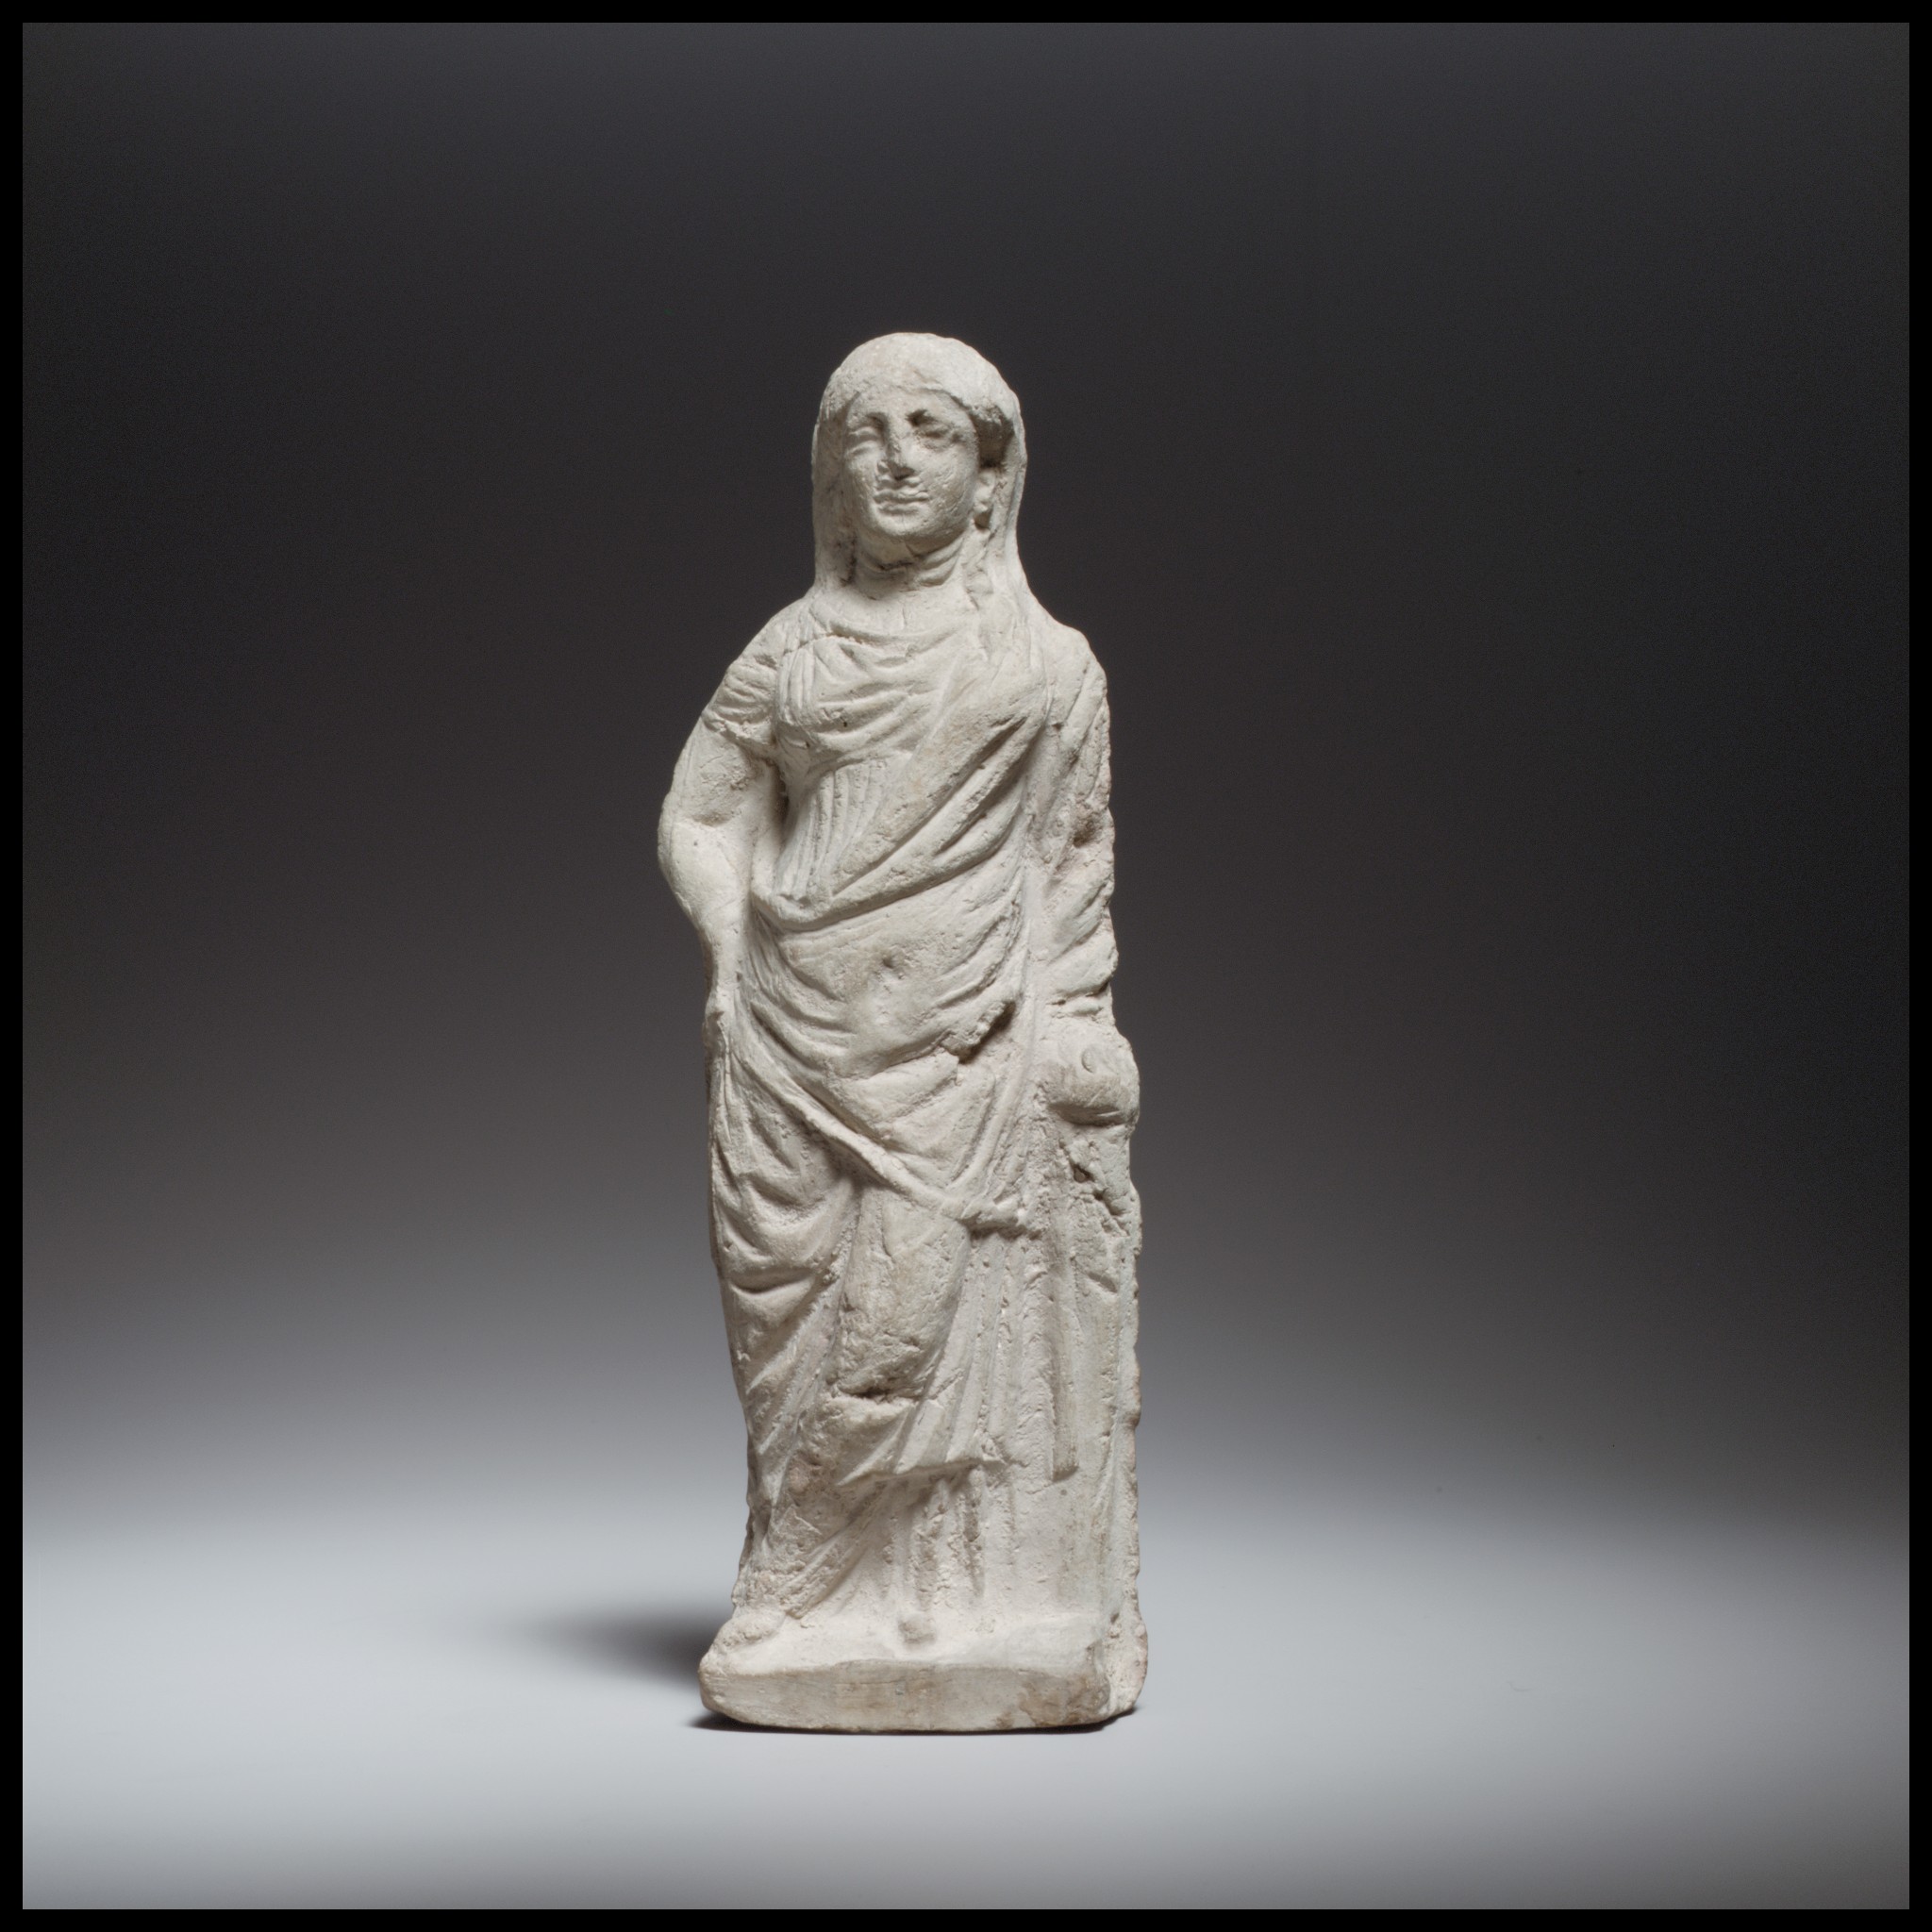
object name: statuette of a woman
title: Terracotta statuette of a woman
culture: cypriot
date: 200-1 BCE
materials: terracotta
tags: women